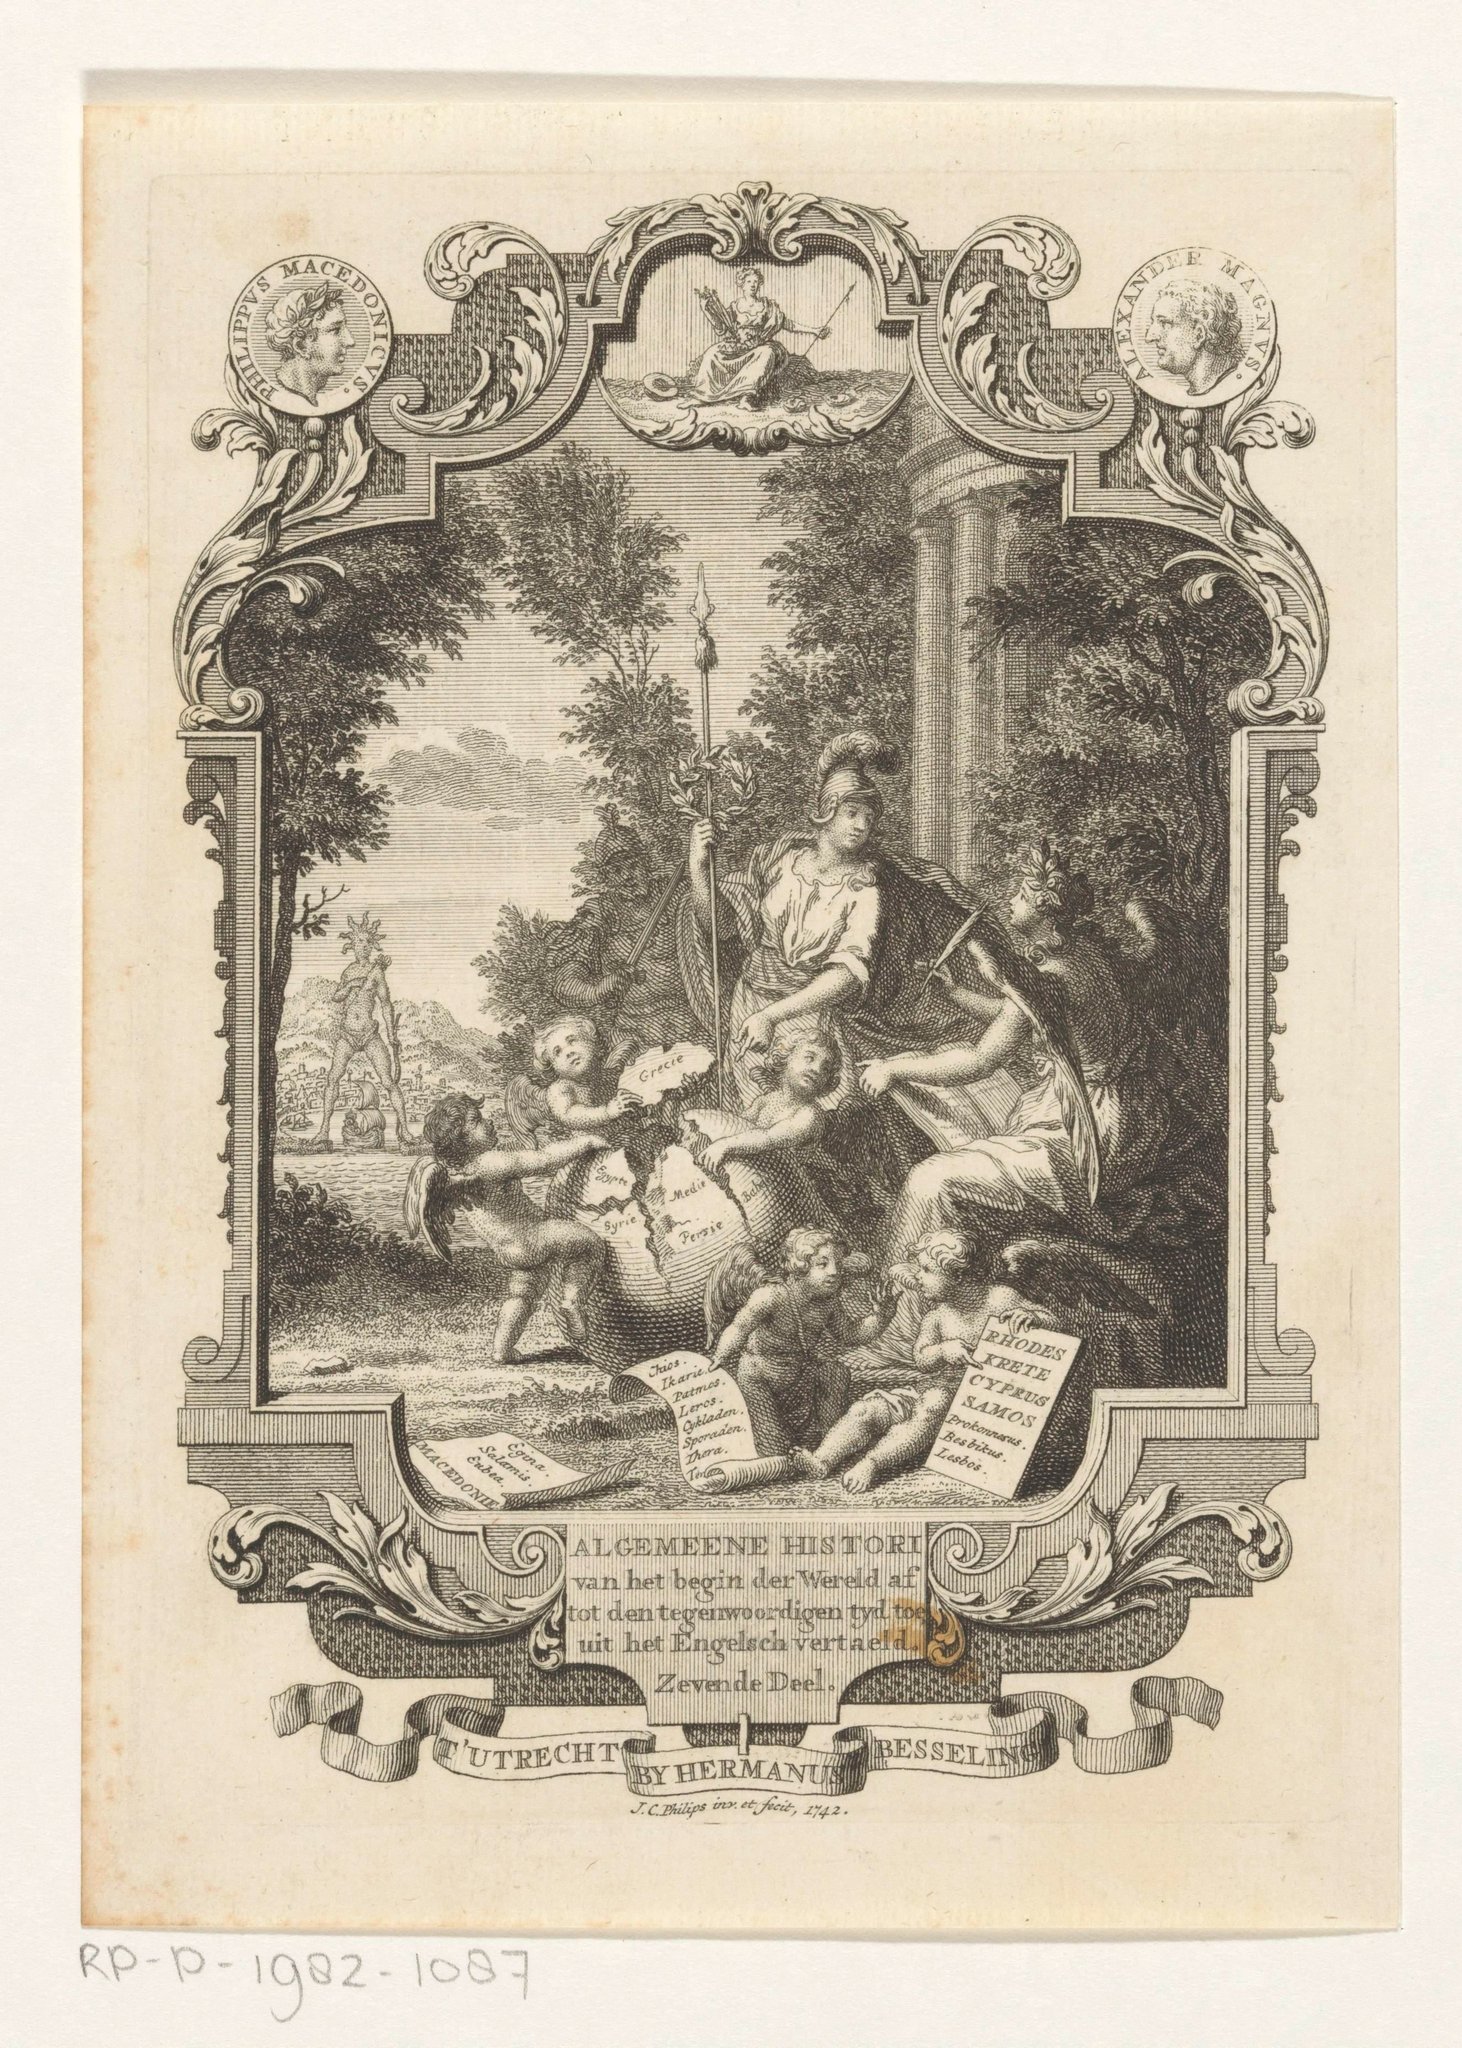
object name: titelblad, titelpagina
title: Cartouche met allegorie op de geschiedenis van Griekenland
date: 1742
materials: paper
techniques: engraving, etching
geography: utrecht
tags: (story of) minerva (pallas, athena), 'historia'; 'historia' (ripa), colossus of rhodes (wonder of the world)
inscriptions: collector's mark: Lugt 2228, collector's mark: Lugt 2760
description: Een landschap met op de achtergrond de Kolos van Rhodos en op de voorgrond enkele figuren bij een wereldbol, waaruit door drie putti parten worden genomen. Rechts staat Minerva naast de schrijvende Geschiedenis. Op de grond zitten twee putti met tablet en papier met Griekse gebieden.